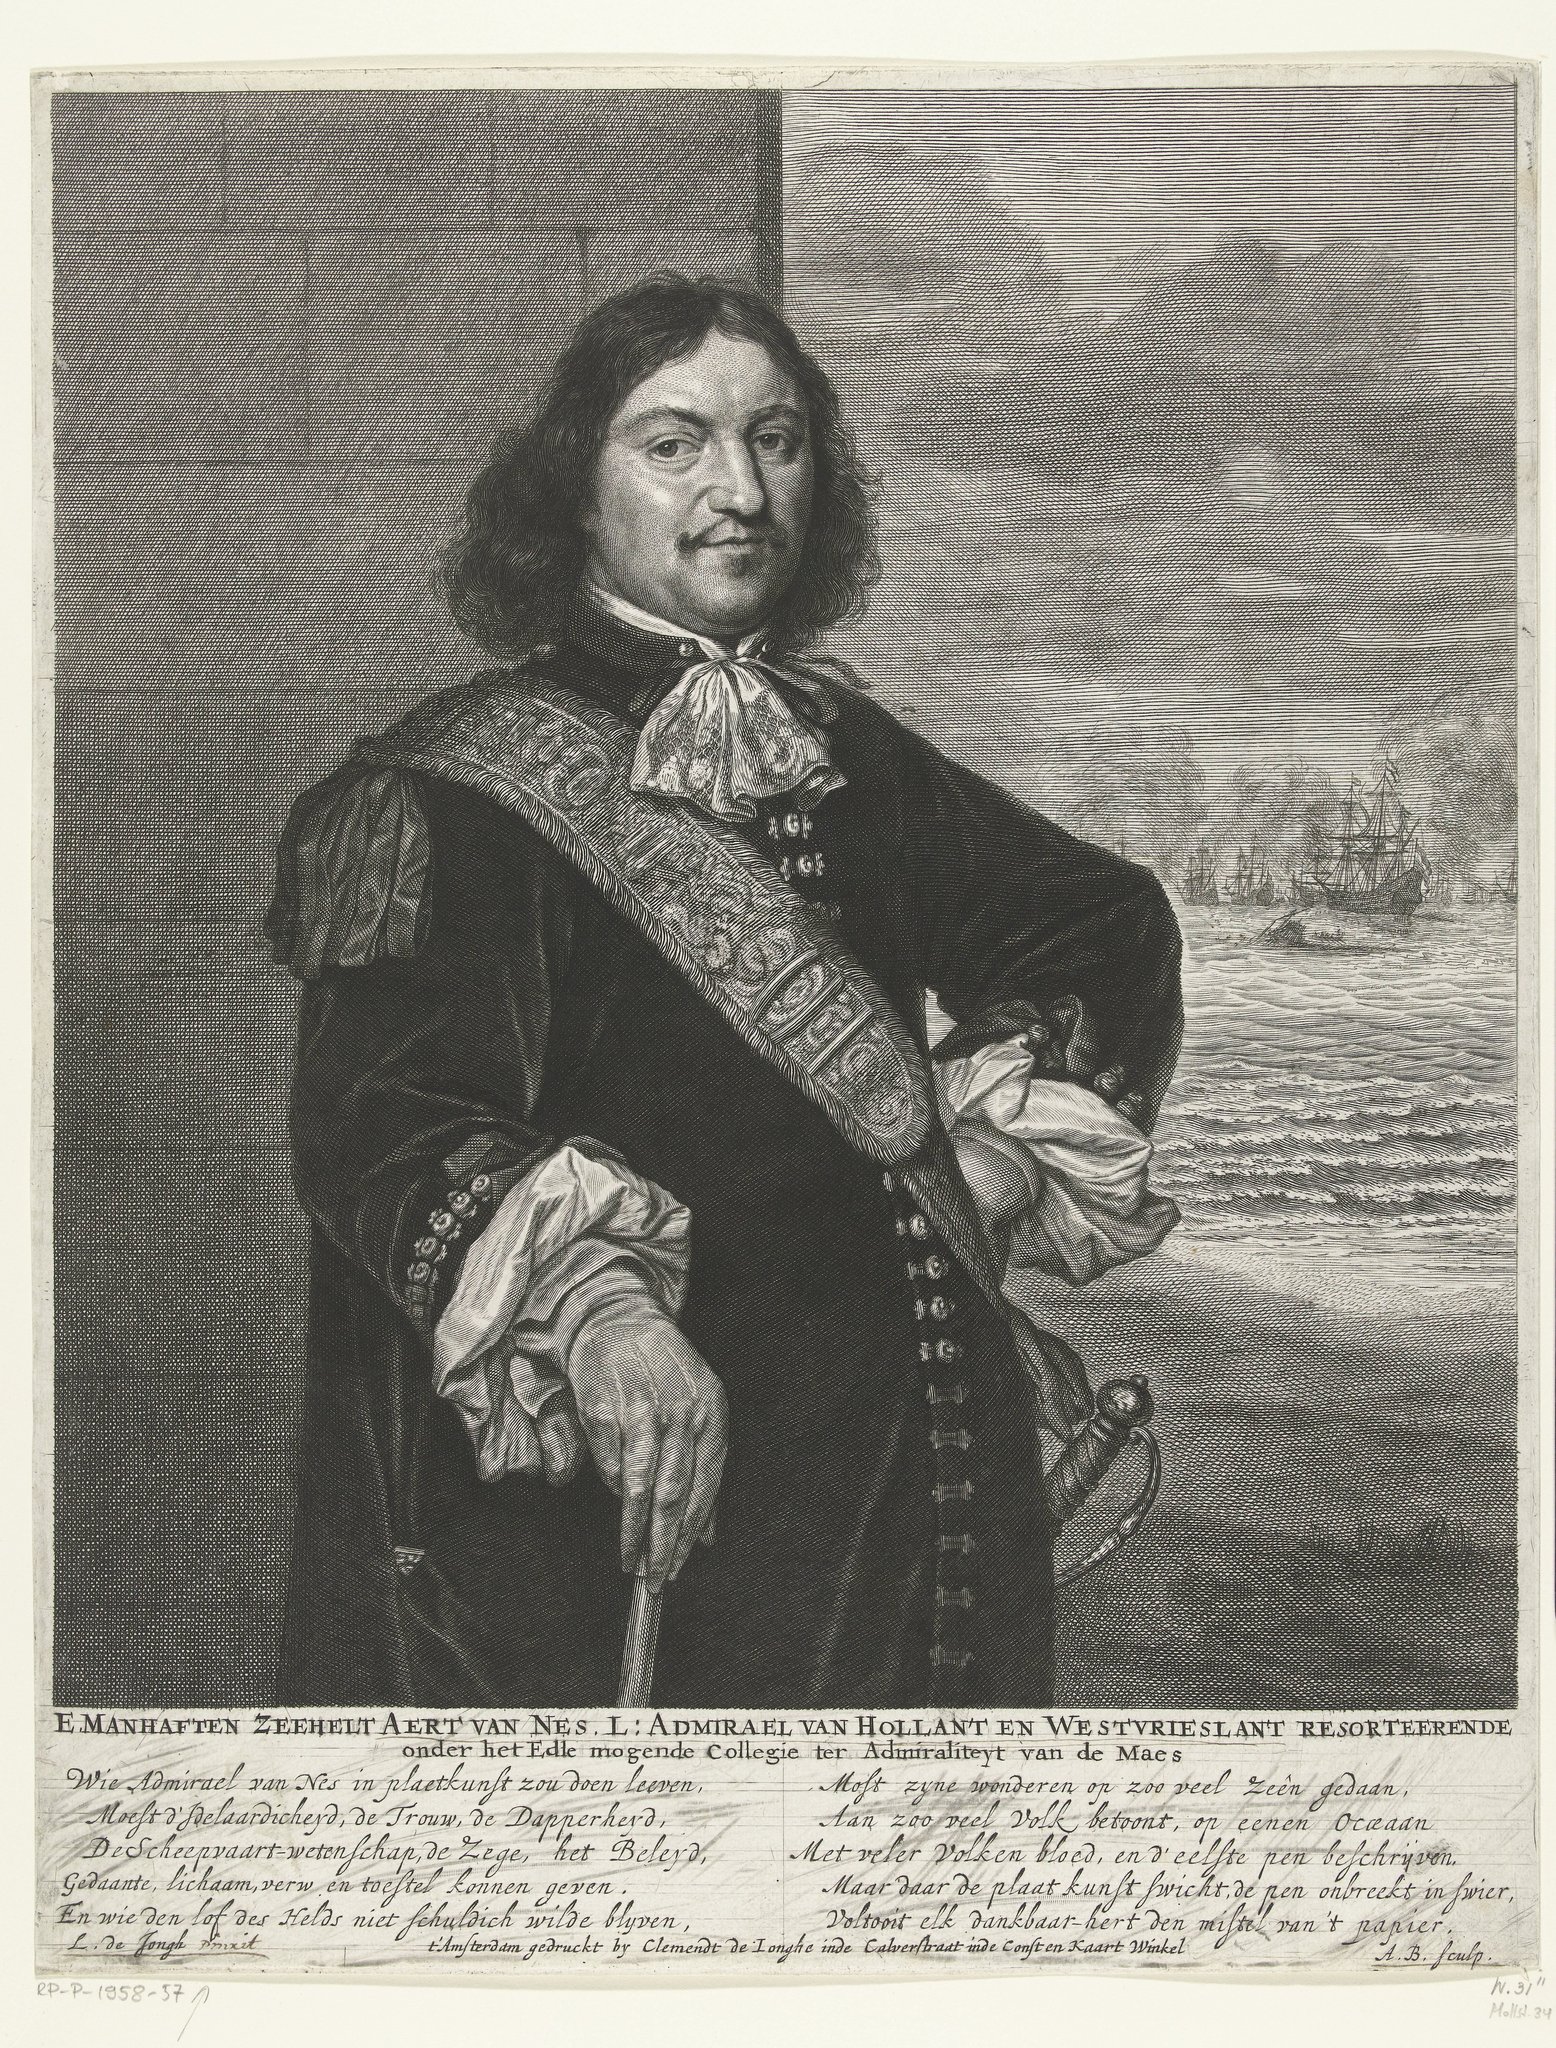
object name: print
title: Portret van Aert Jansz. van Nes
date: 1670-1690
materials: paper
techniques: engraving, roulette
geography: netherlands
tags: rotterdam, commander-in-chief, admiral (+ naval force)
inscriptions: collector's mark: Lugt 2228, collector's mark: Lugt 533b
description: Portret van de marineofficier Aert Jansz. van Nes. Van Nes was een luitenant-admiraal die zich vooral in de Engelse oorlogen had bewezen. Op de achtergrond een zeeslag. Van Nes staat aan de kust voor een muur. Onder het portret een Nederlands vers op Van Nes en zijn leven.